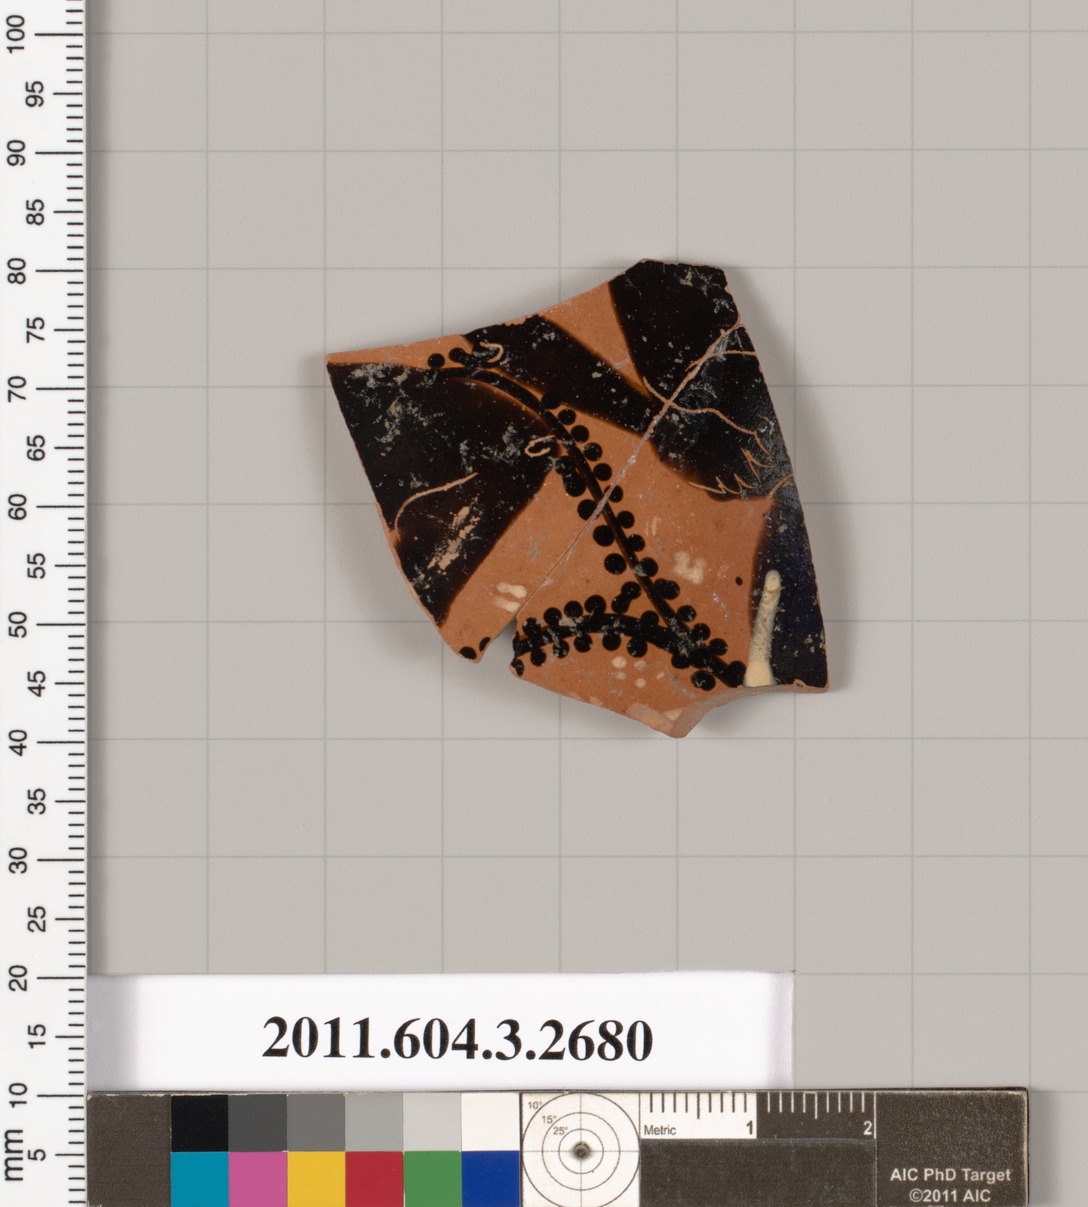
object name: oinochoe fragment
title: Terracotta fragment of an oinochoe (jug)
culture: greek, attic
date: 525-501 BCE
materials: terracotta